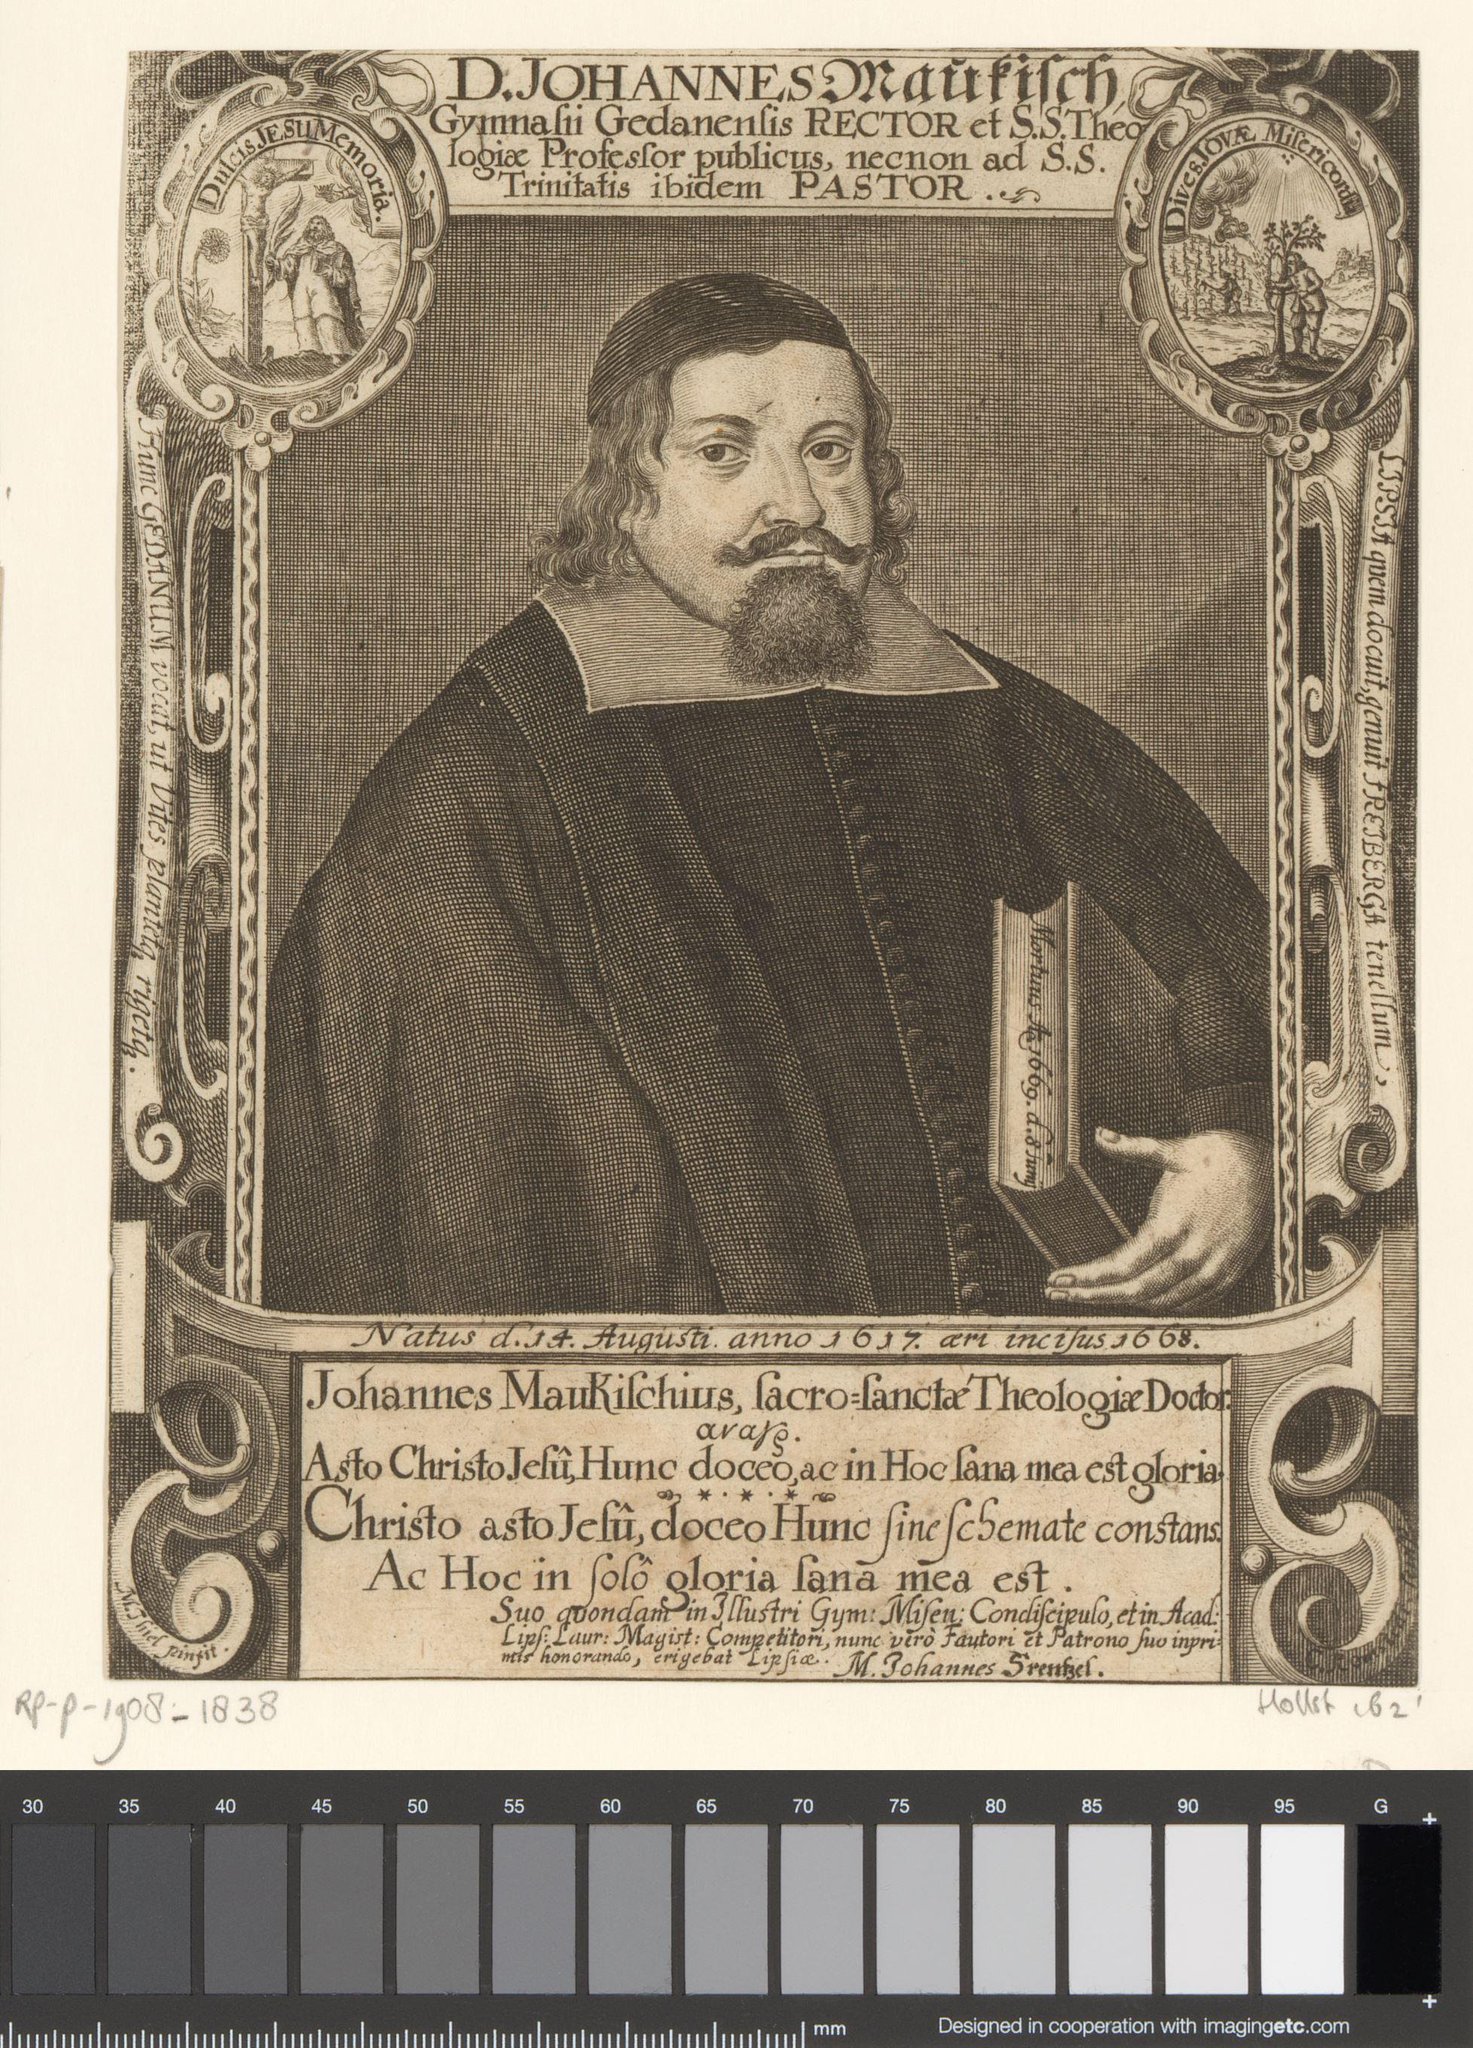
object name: print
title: Portret van Johann Maukisch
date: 1665-1721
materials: paper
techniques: engraving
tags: theologian, historical persons, book, abstract ideas and concepts (+ emblematical representation of concept)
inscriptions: collector's mark: Lugt 2228